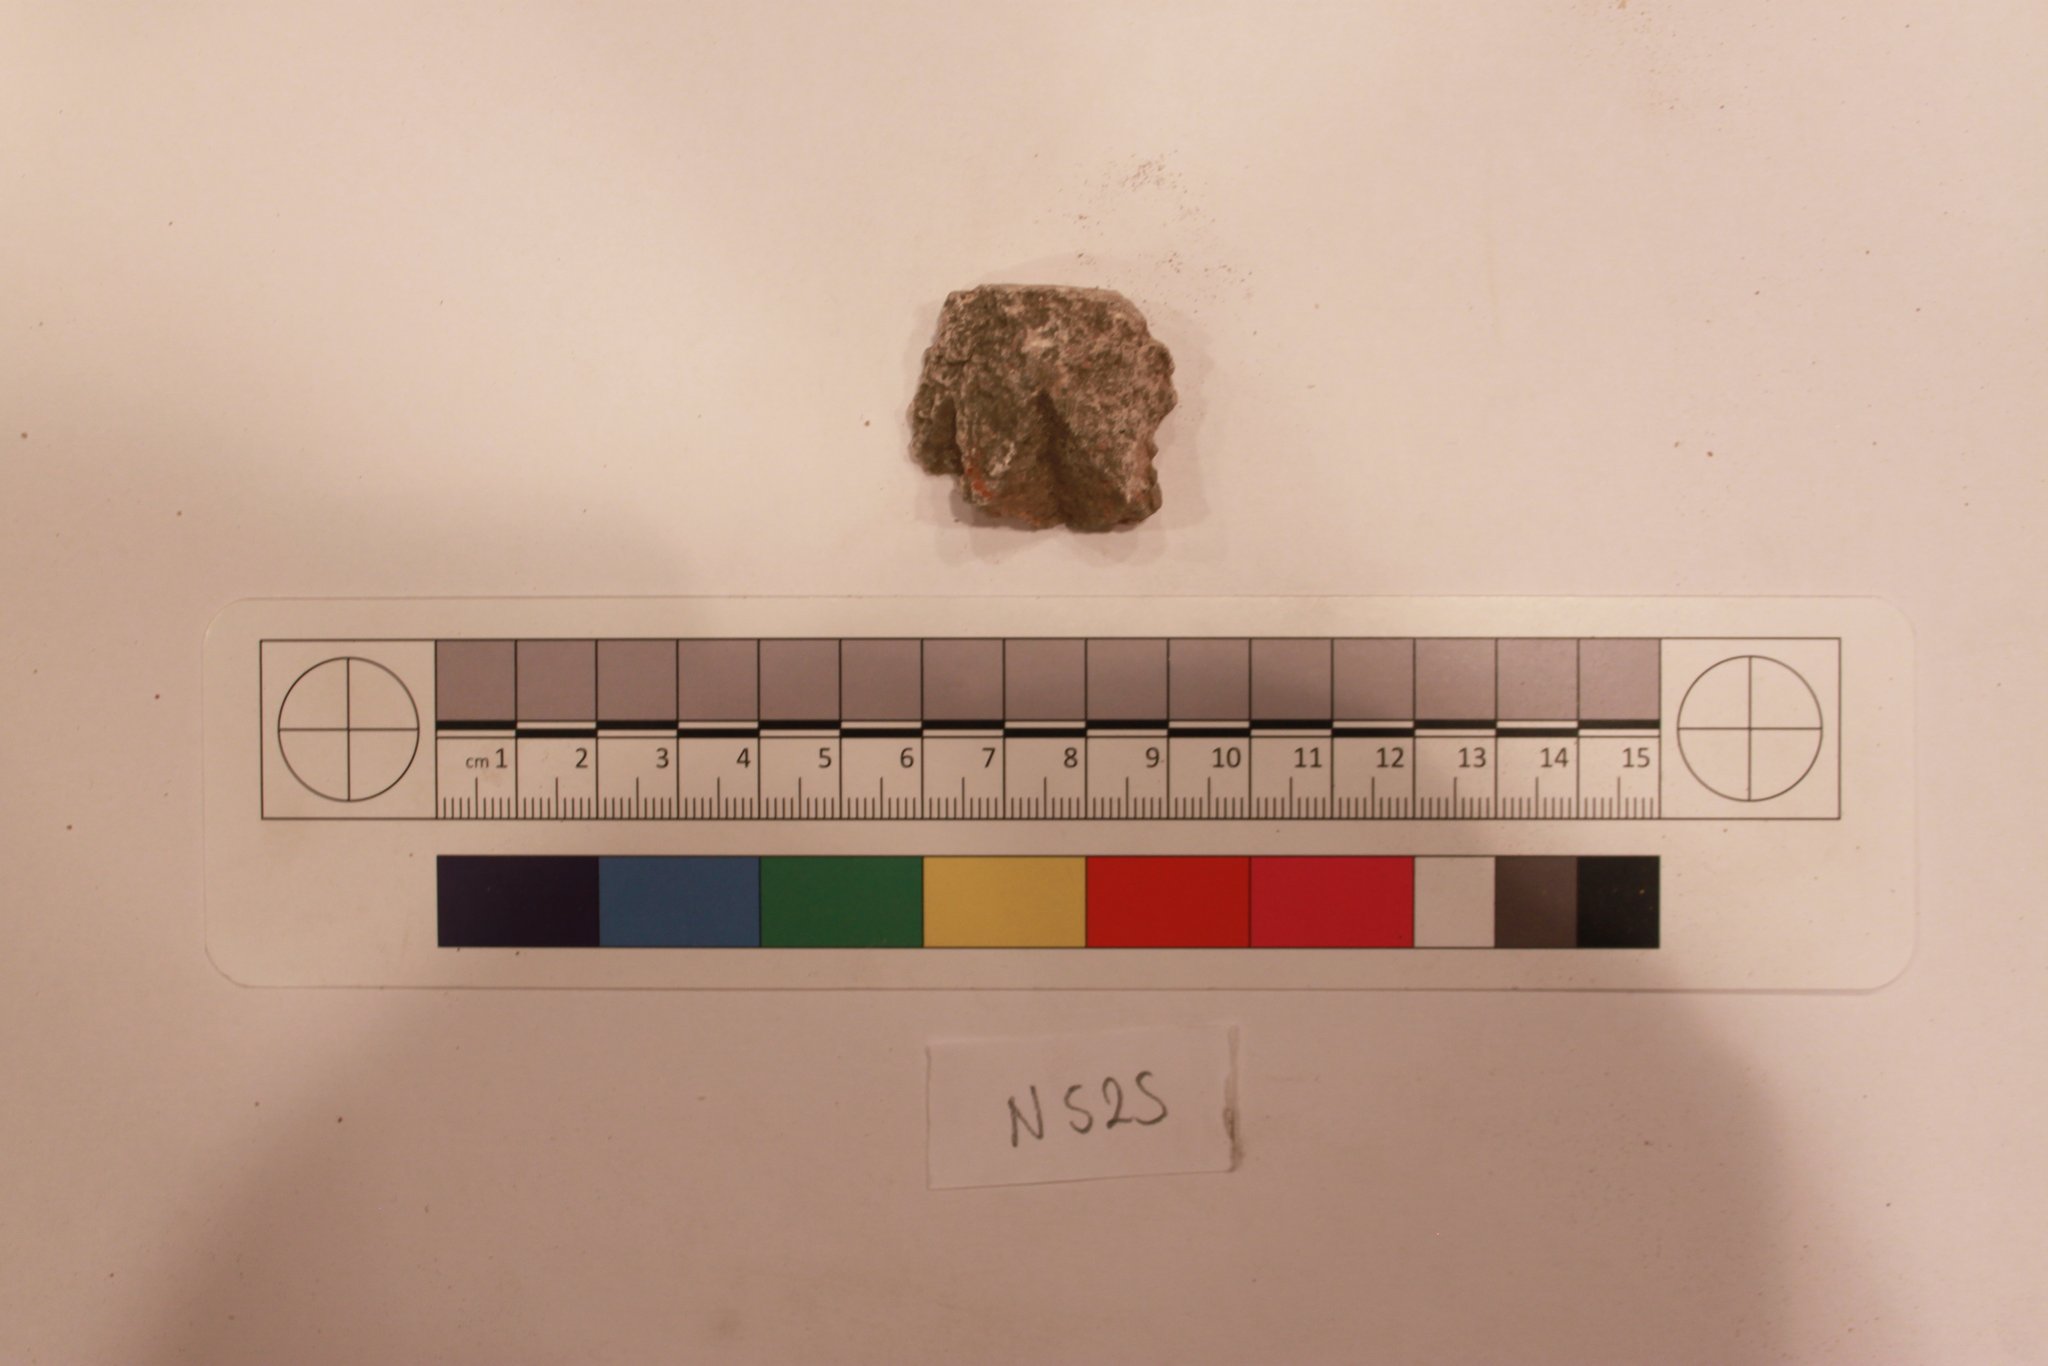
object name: fragment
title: Stucco Fragment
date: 701-1200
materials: plaster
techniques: carving, painting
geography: iran